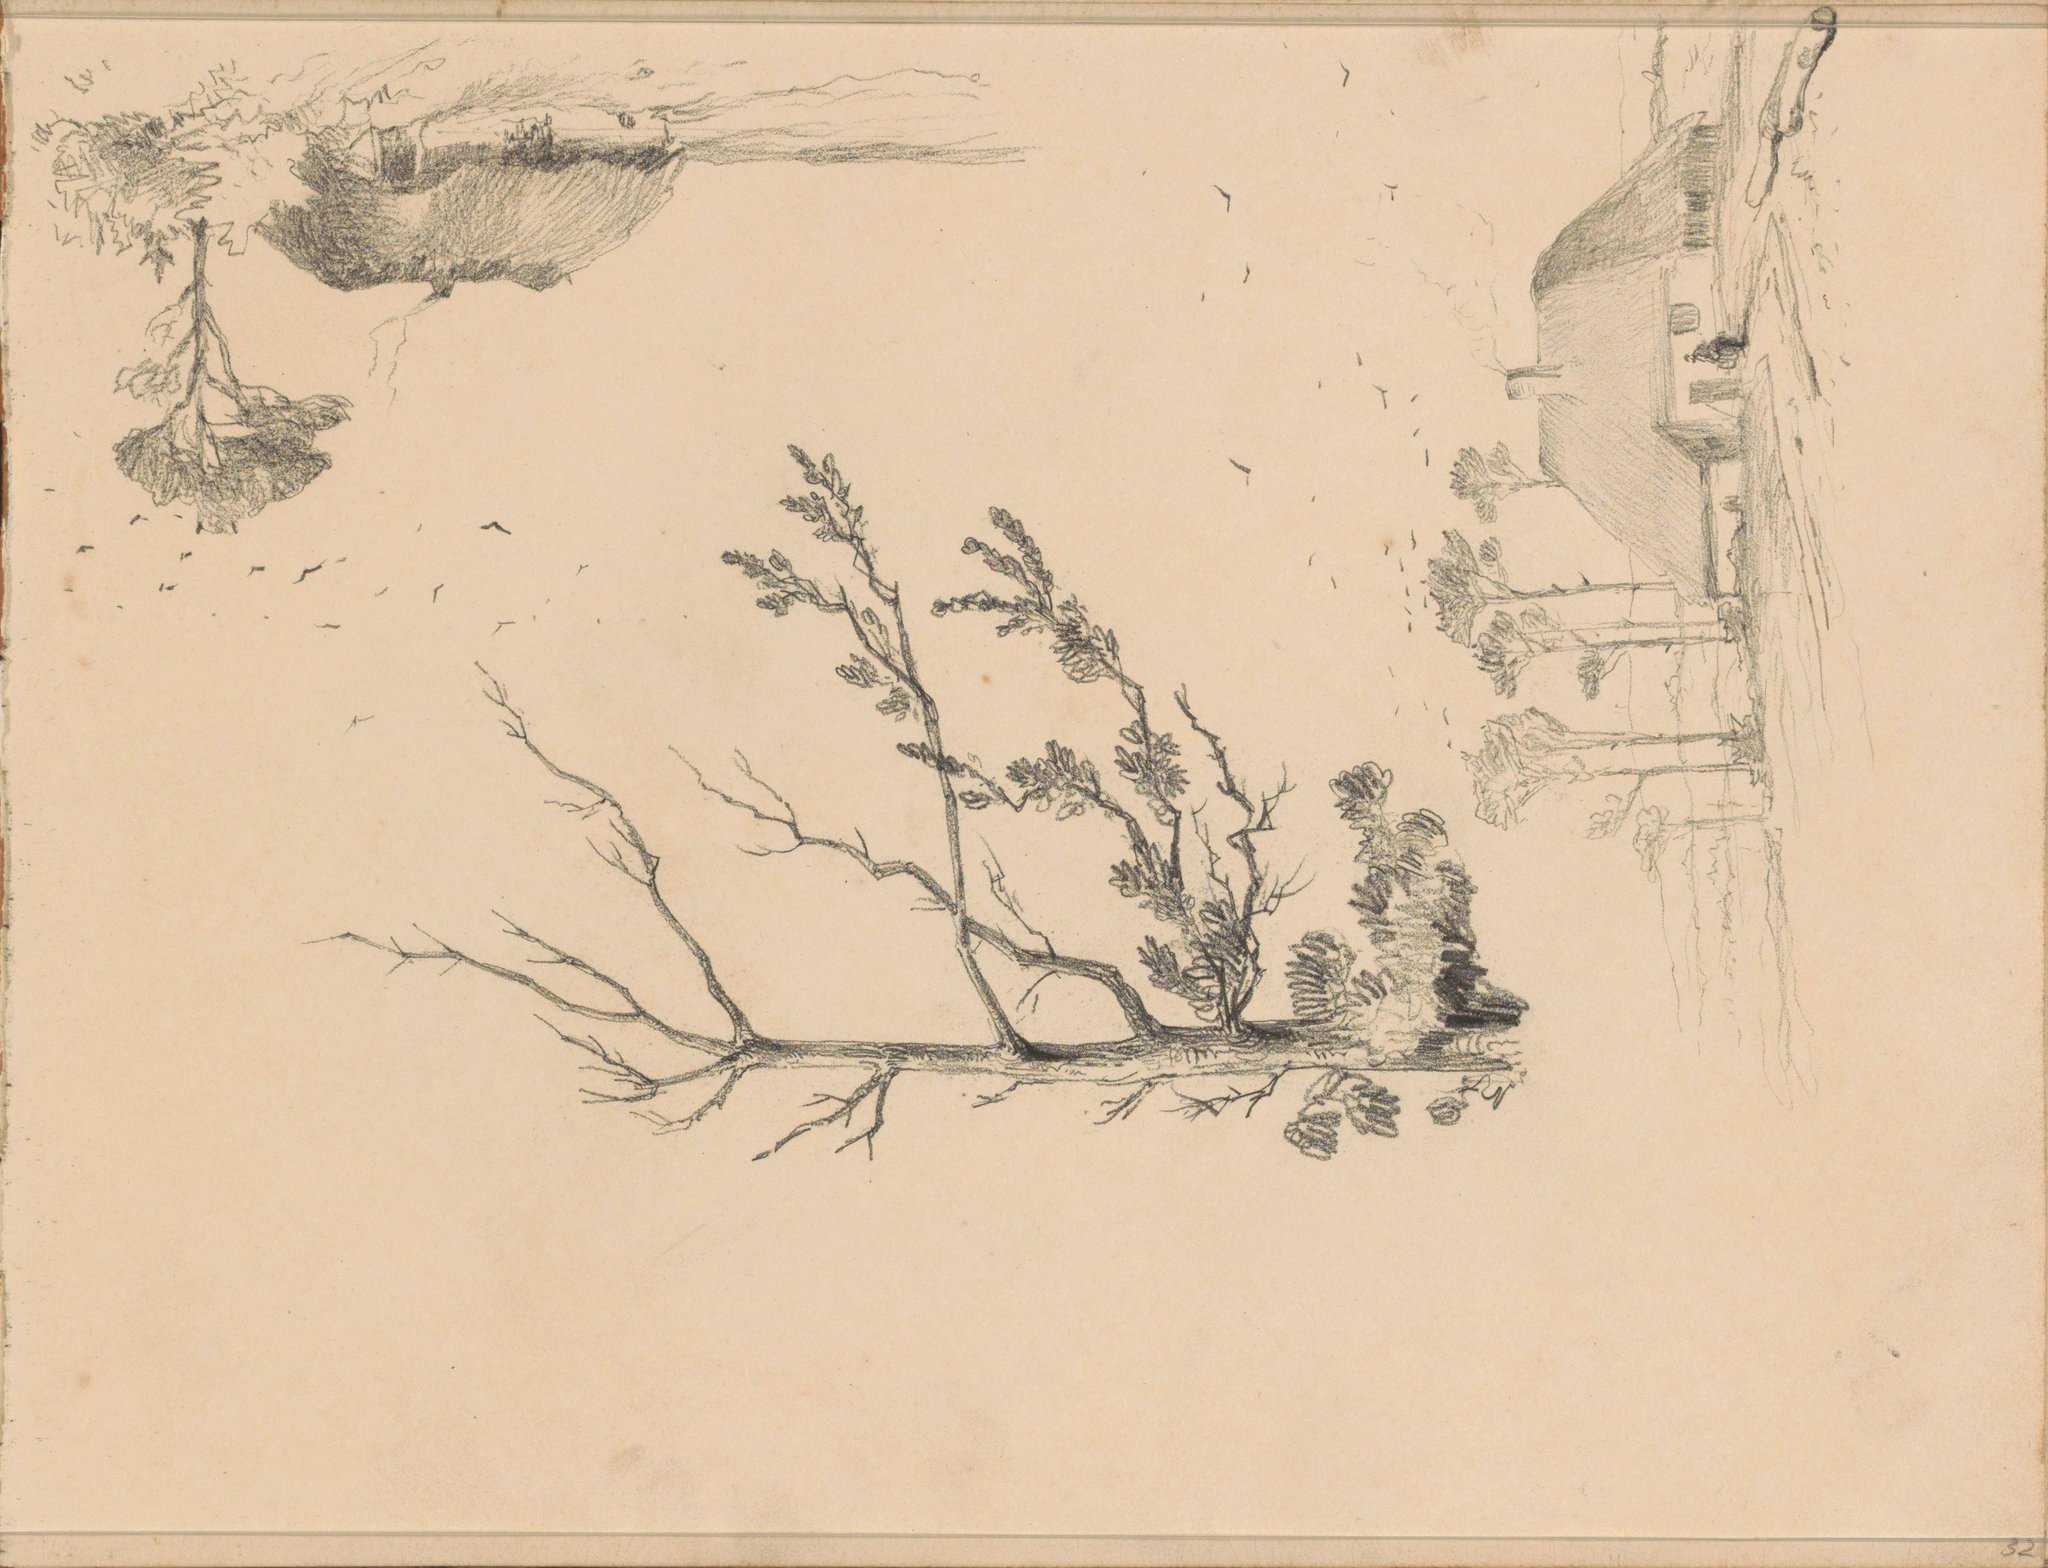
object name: sketchbook leaf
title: Bloeiende boom en een boederij tussen de bomen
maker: johannes tavenraat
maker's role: draughtsman, painter, print maker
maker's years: 1809-1881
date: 1840-1845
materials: paper, pencil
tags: trees, farm (building)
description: Blad 32 recto uit een schetsboek met 43 bladen.